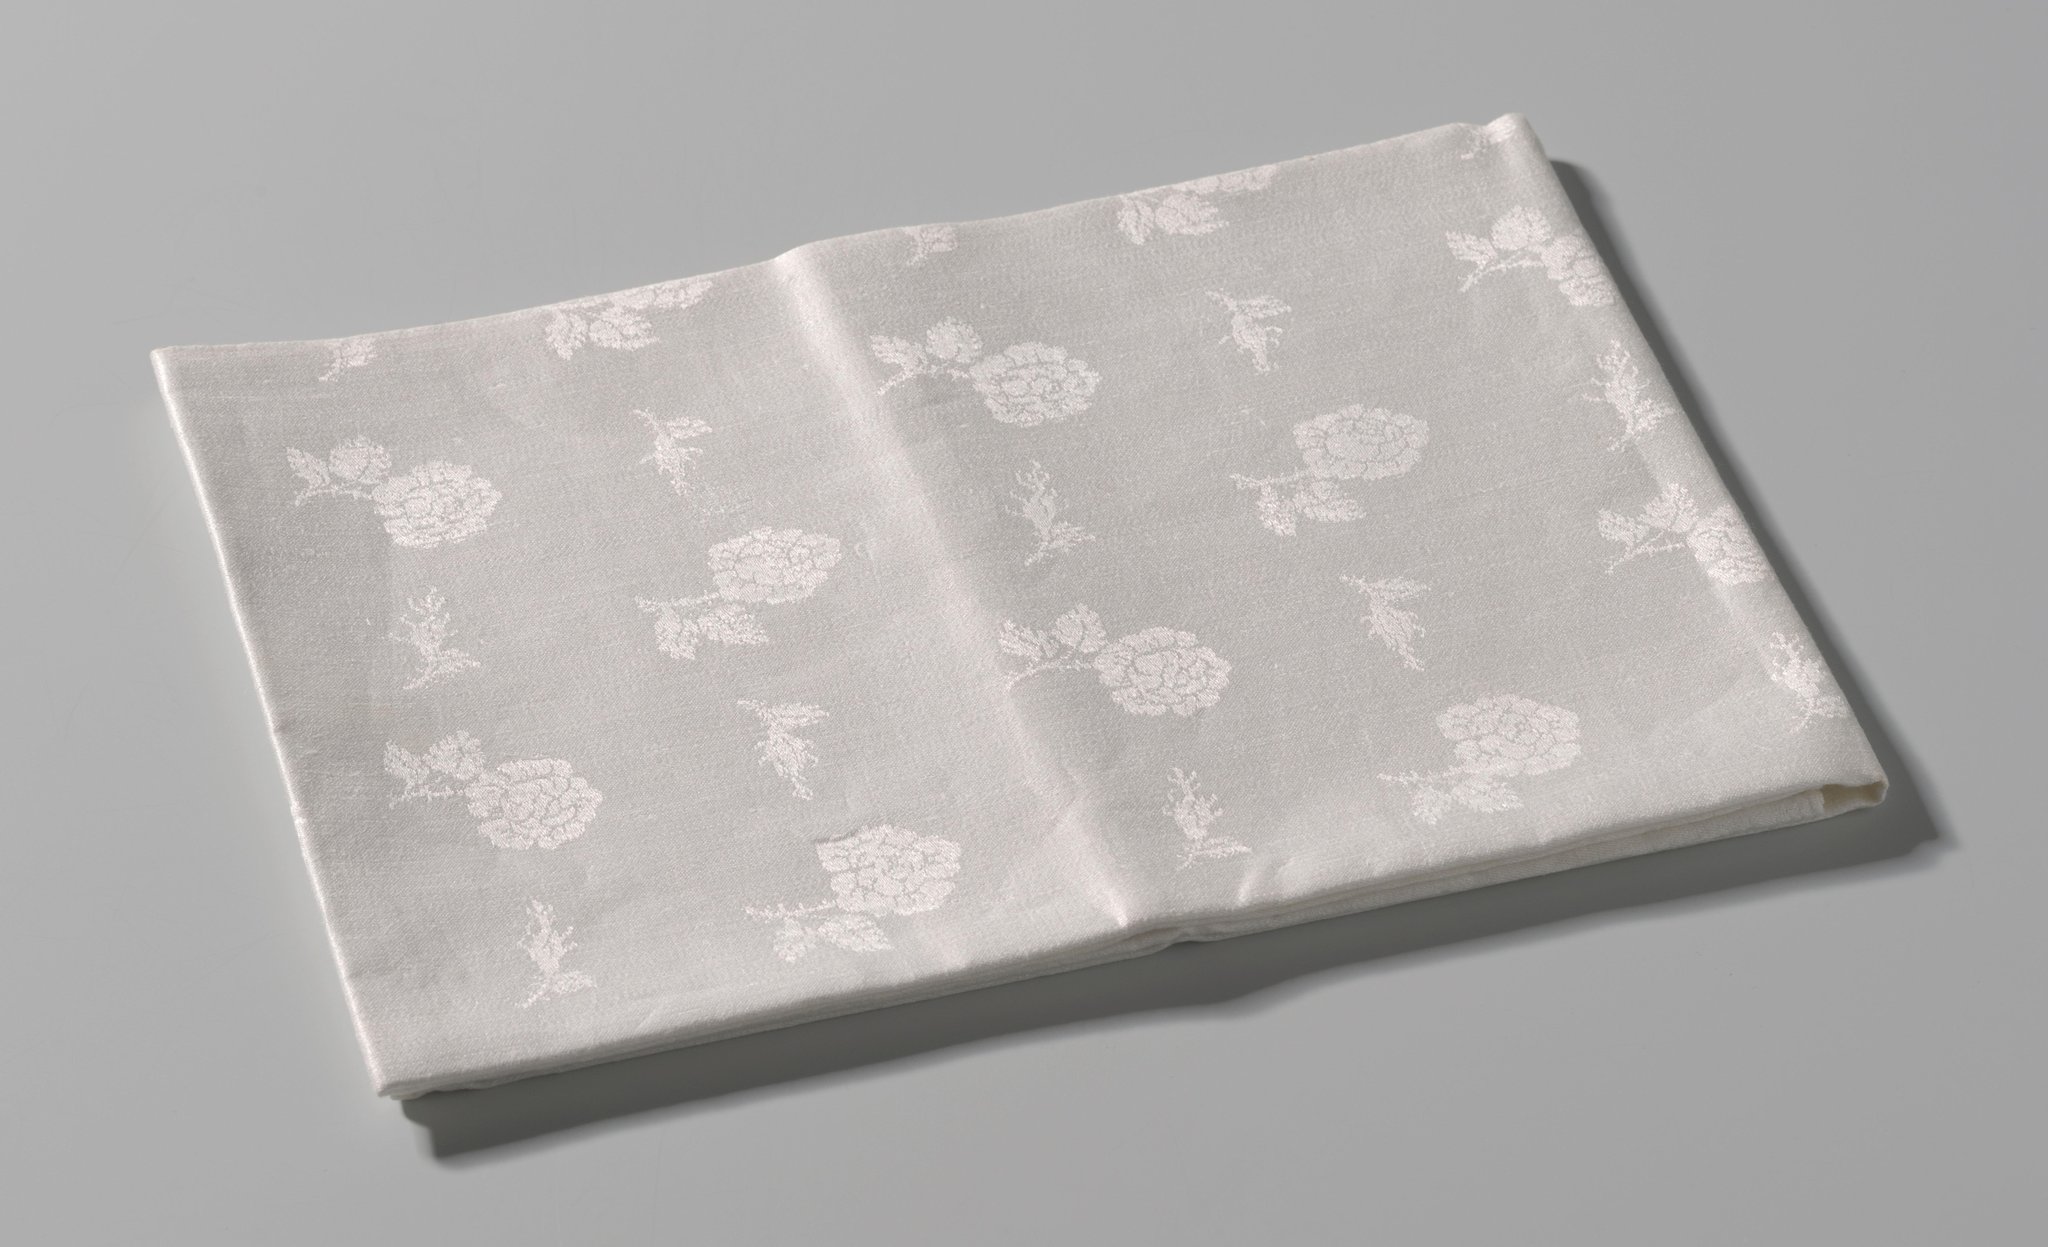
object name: napkin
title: Servet van wit linnendamast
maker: Anonymous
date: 1770-1795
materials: linen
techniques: damask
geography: germany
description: Wit linnen damasten servet met een patroon roosjes en rozenknoppen met een rand van rozetakken en een bloemboeket in de hoeken. Merk BSG en 42.